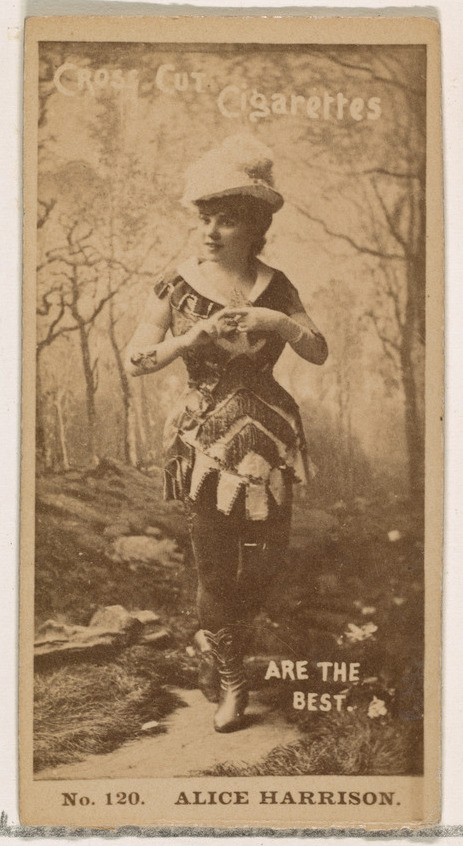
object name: print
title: Card Number 120, Alice Harrison, from the Actors and Actresses series (N145-2) issued by Duke Sons & Co. to promote Cross Cut Cigarettes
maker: w. duke, sons & co.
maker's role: publisher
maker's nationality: american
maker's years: 1870-1920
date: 1880-1889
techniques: albumen silver print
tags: portraits,women,actresses